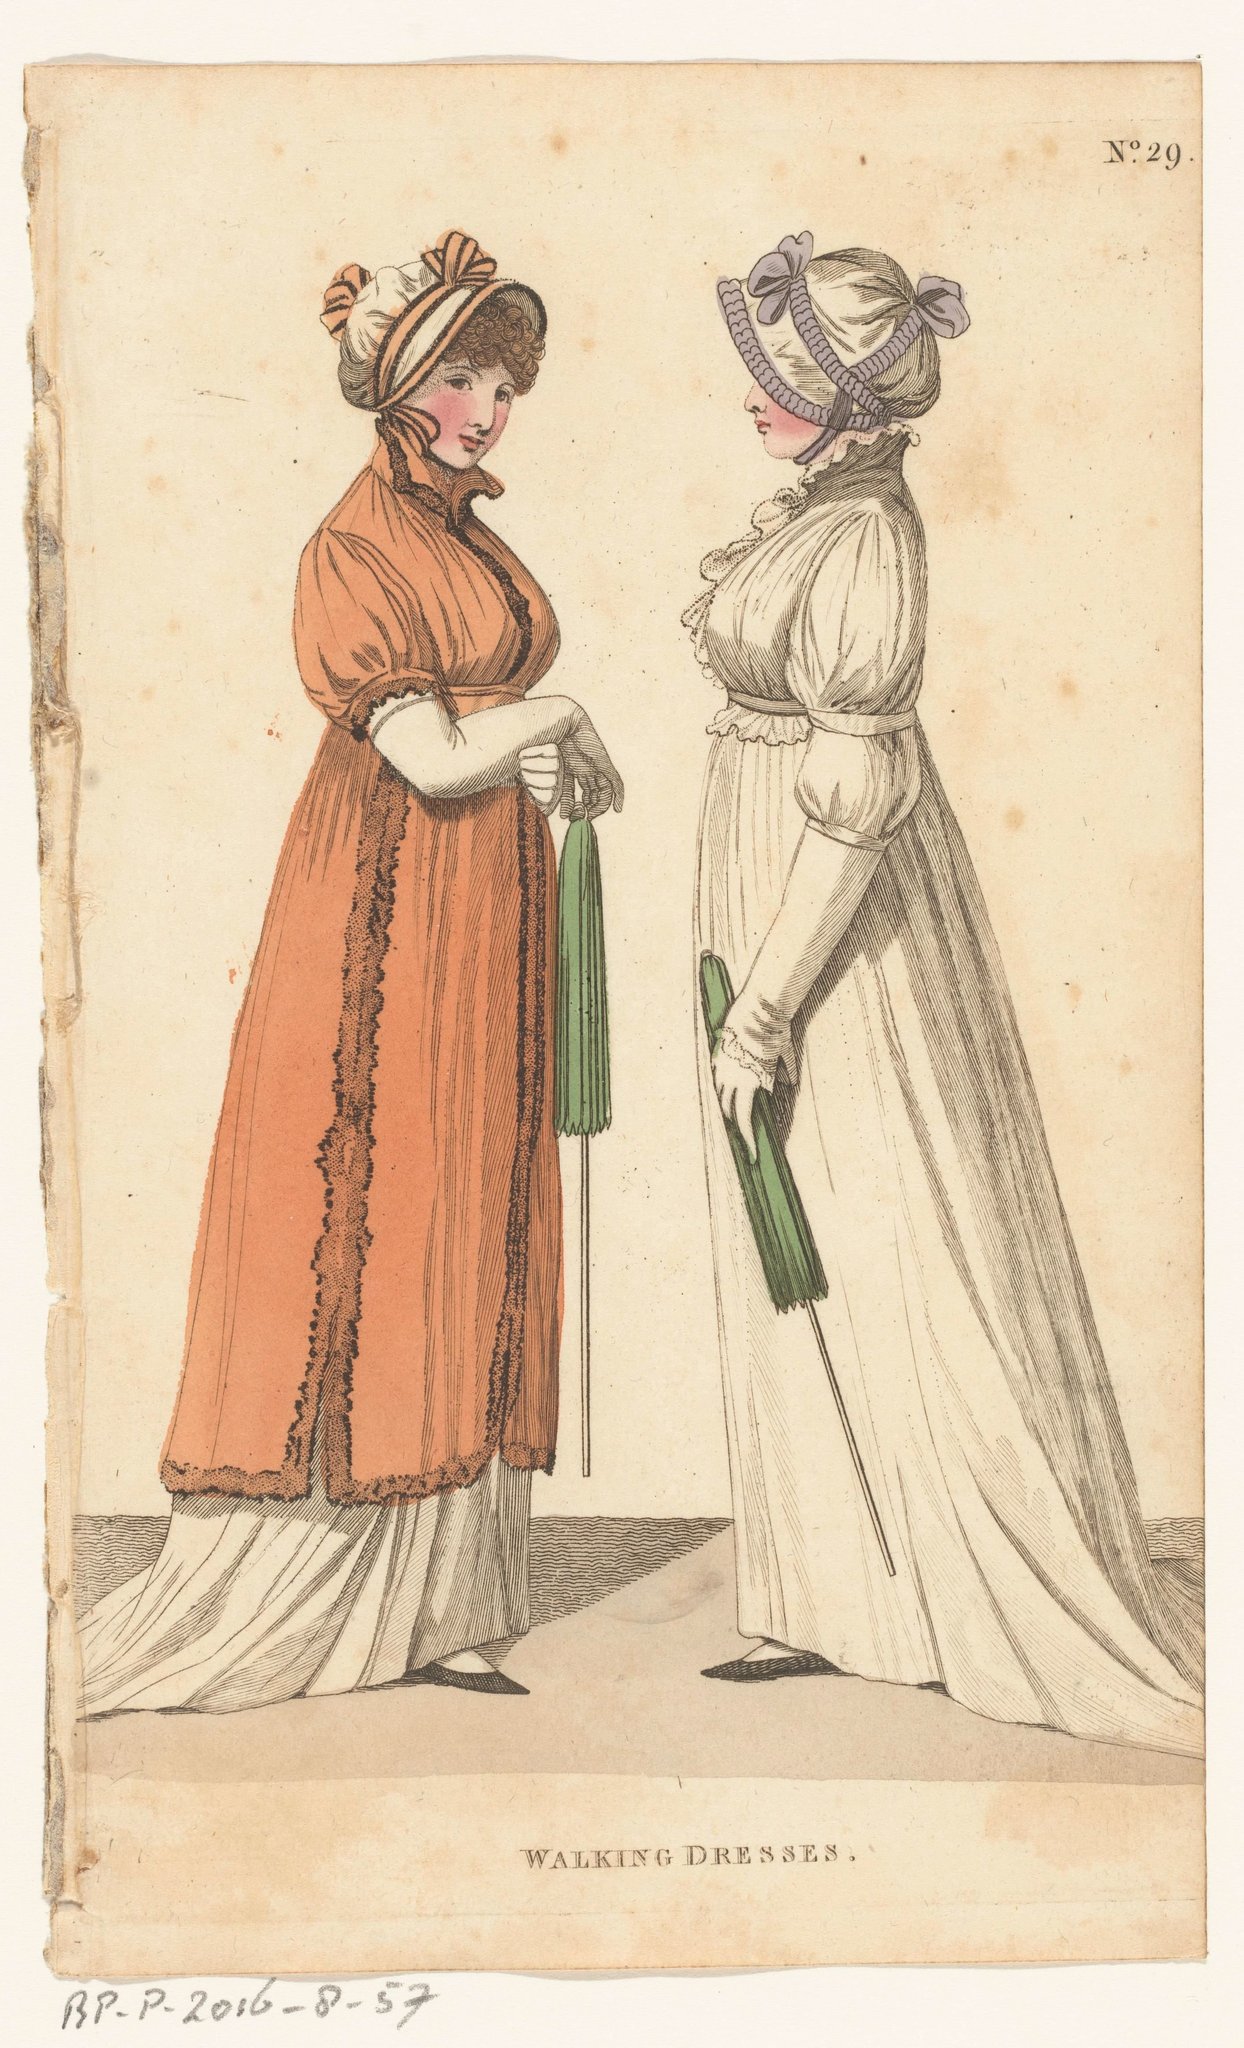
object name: fashion print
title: Magazine of Female Fashions of London and Paris. No. 29: Walking Dresses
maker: richard phillips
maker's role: bookseller, publisher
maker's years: 1767-1840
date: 1798-1806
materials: paper, ink, watercolor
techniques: engraving, etching, hand coloring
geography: london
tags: dress, gown: walking dress (+ women's clothes), fashion plates, head-gear: hat (+ women's clothes), parasol, sunshade (+ women's clothes)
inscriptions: collector's mark: Lugt 2228, : ‘Walking Dresses’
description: Twee vrouwen in Engels wandelkostuum, parasol in de hand.